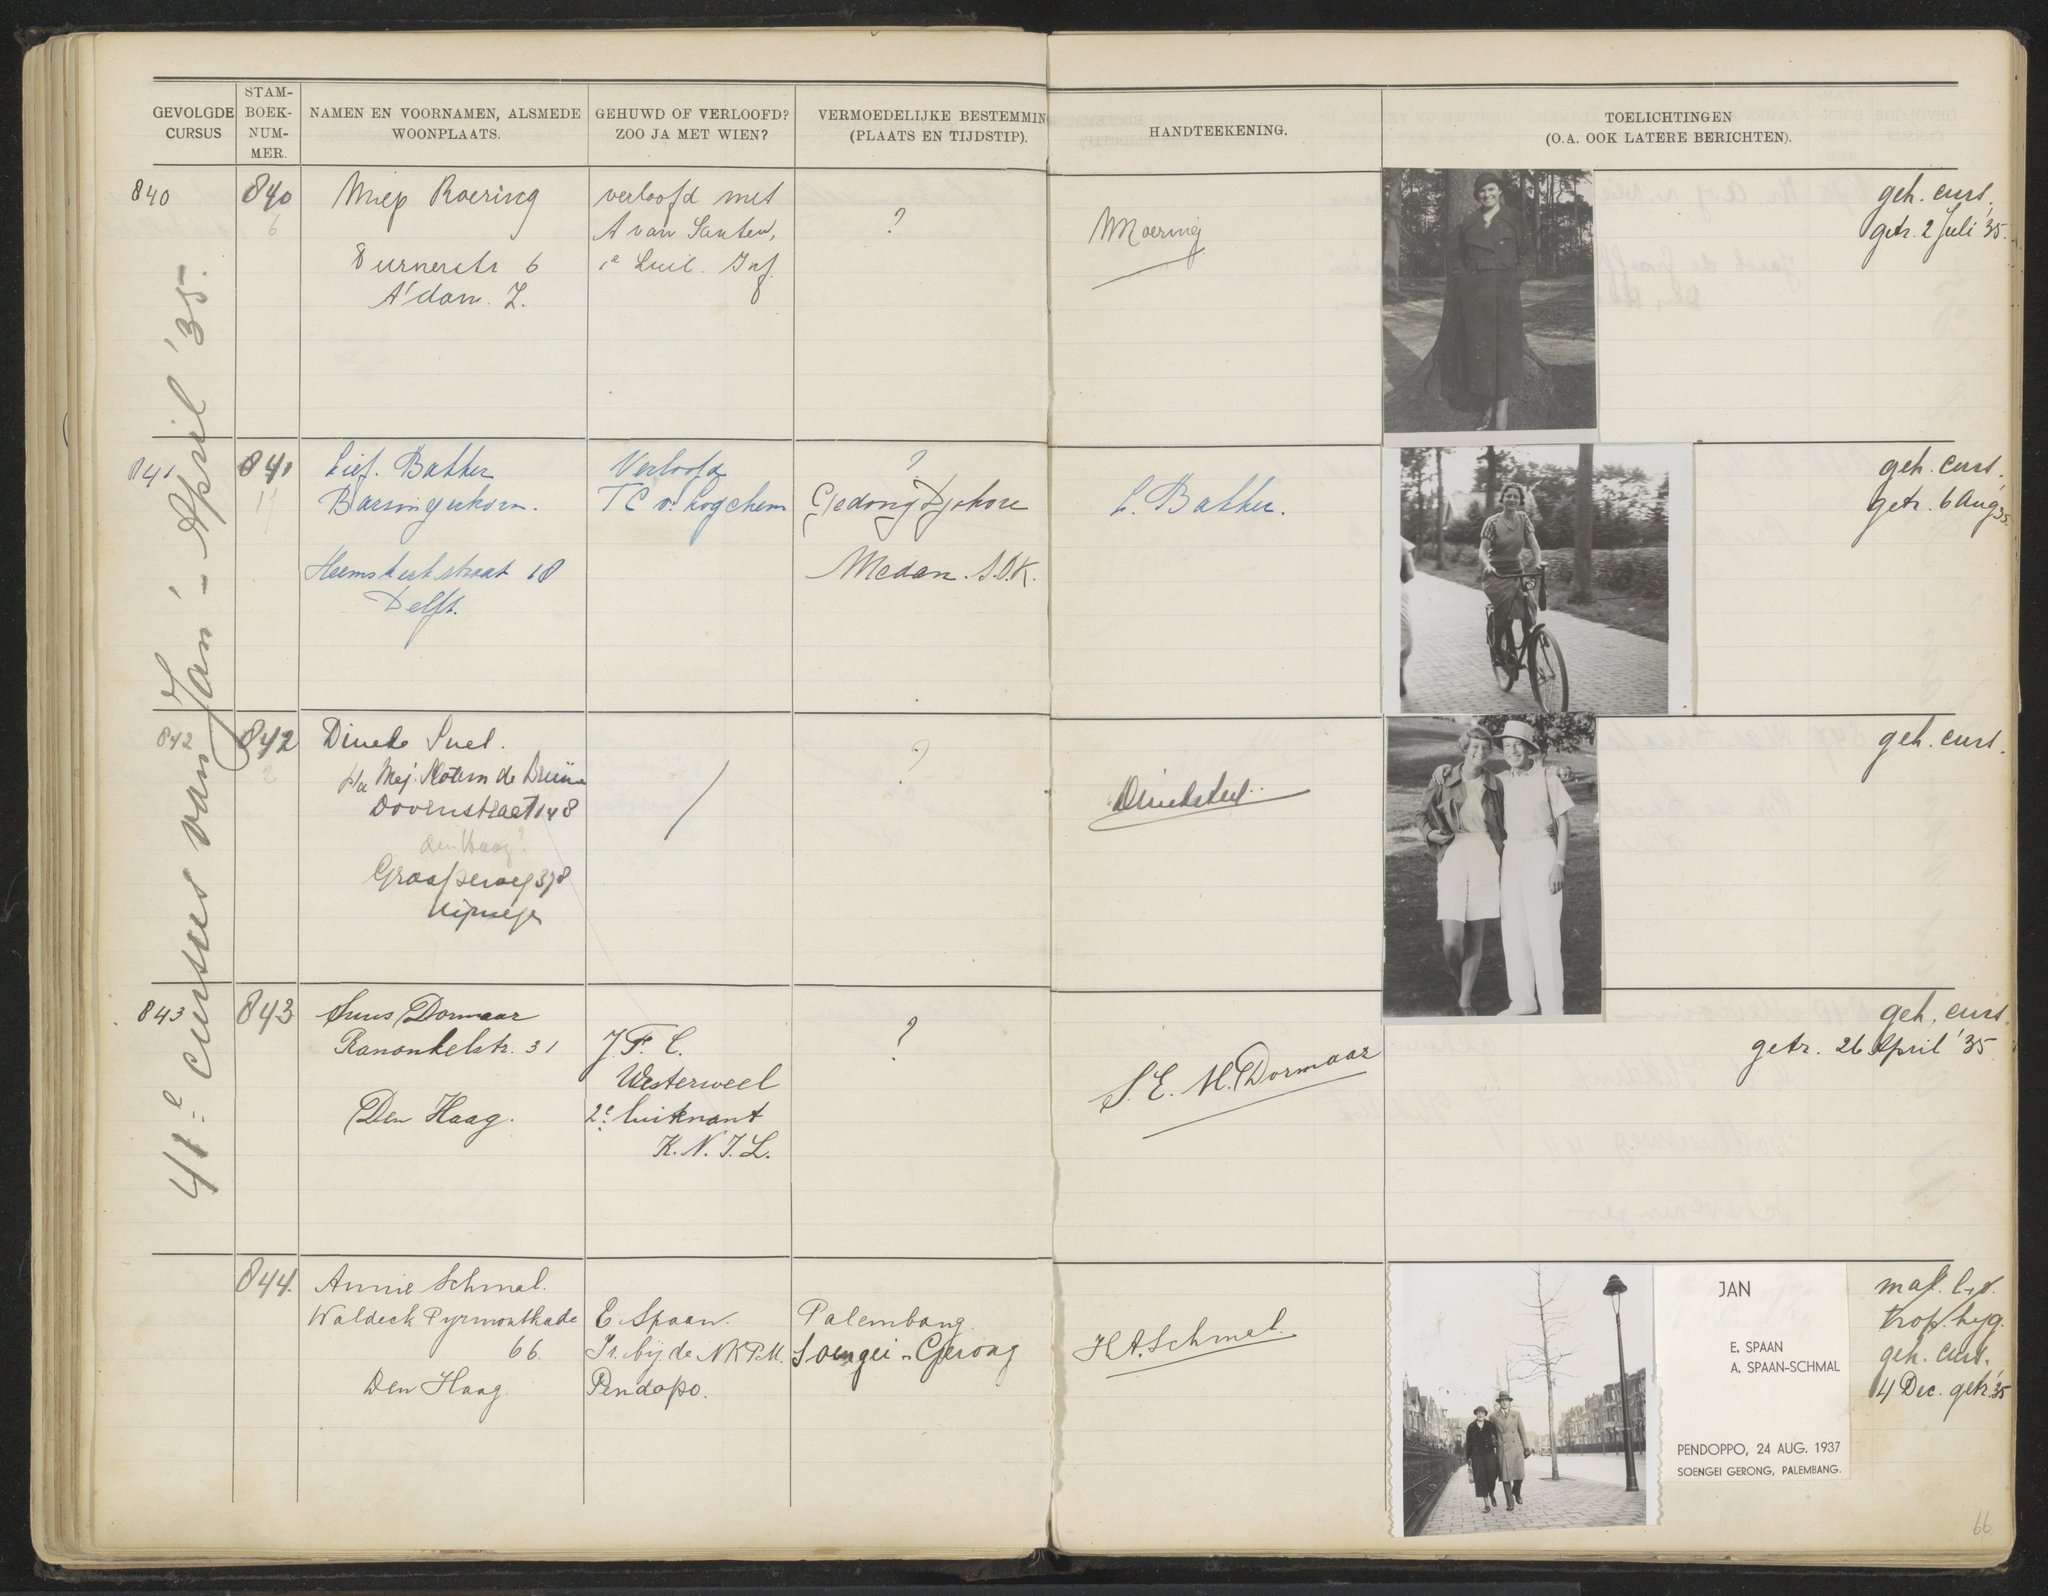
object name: photograph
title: Blad 66 uit Stamboek van de leerlingen der Koloniale School voor Meisjes en Vrouwen te 's-Gravenhage deel II (1930-1949)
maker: Anonymous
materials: paper, photographic support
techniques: photography, printing, writing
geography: the hague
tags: further education (+ pupil), further education, the hague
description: Twee pagina's met gegevens van de deelnemers aan de 41e driemaandelijkse cursus van januari tot april 1935, stamboeknummers 840 tot en met 844. Onderdeel van Stamboek van de leerlingen der Koloniale School voor Meisjes en Vrouwen te 's-Gravenhage deel II (1930-1949).